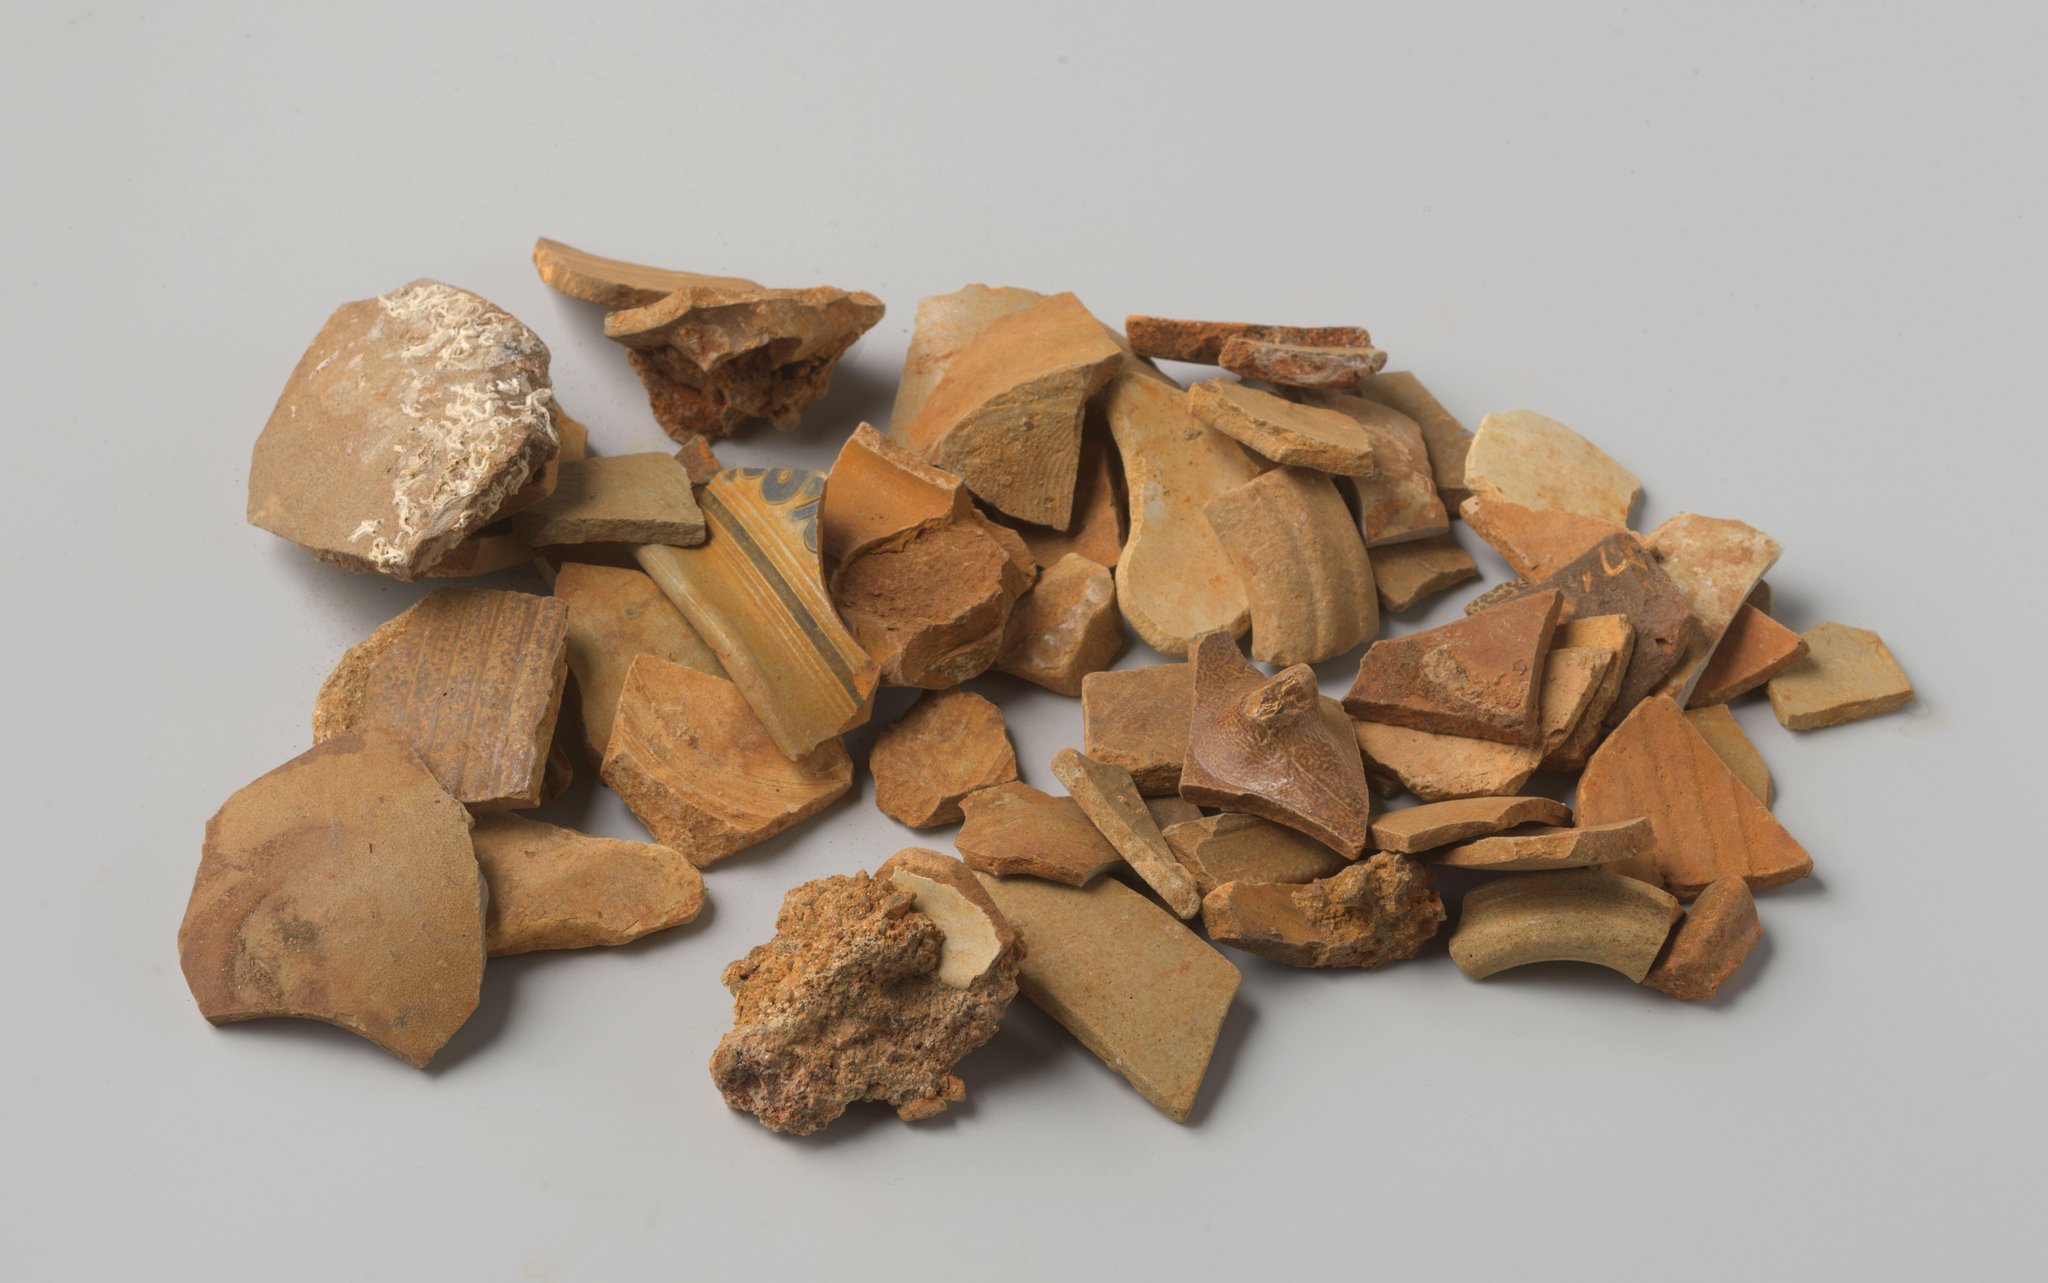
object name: sherd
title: Scherven steengoed en aardewerk uit het wrak van de Oost-Indiëvaarder Hollandia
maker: Anonymous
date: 1700-1743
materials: earthenware, glaze, stoneware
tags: verenigde oostindische compagnie, hollandia (schip), annet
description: Scherven steengoed en roodbakkend aardewerk met glazuur.